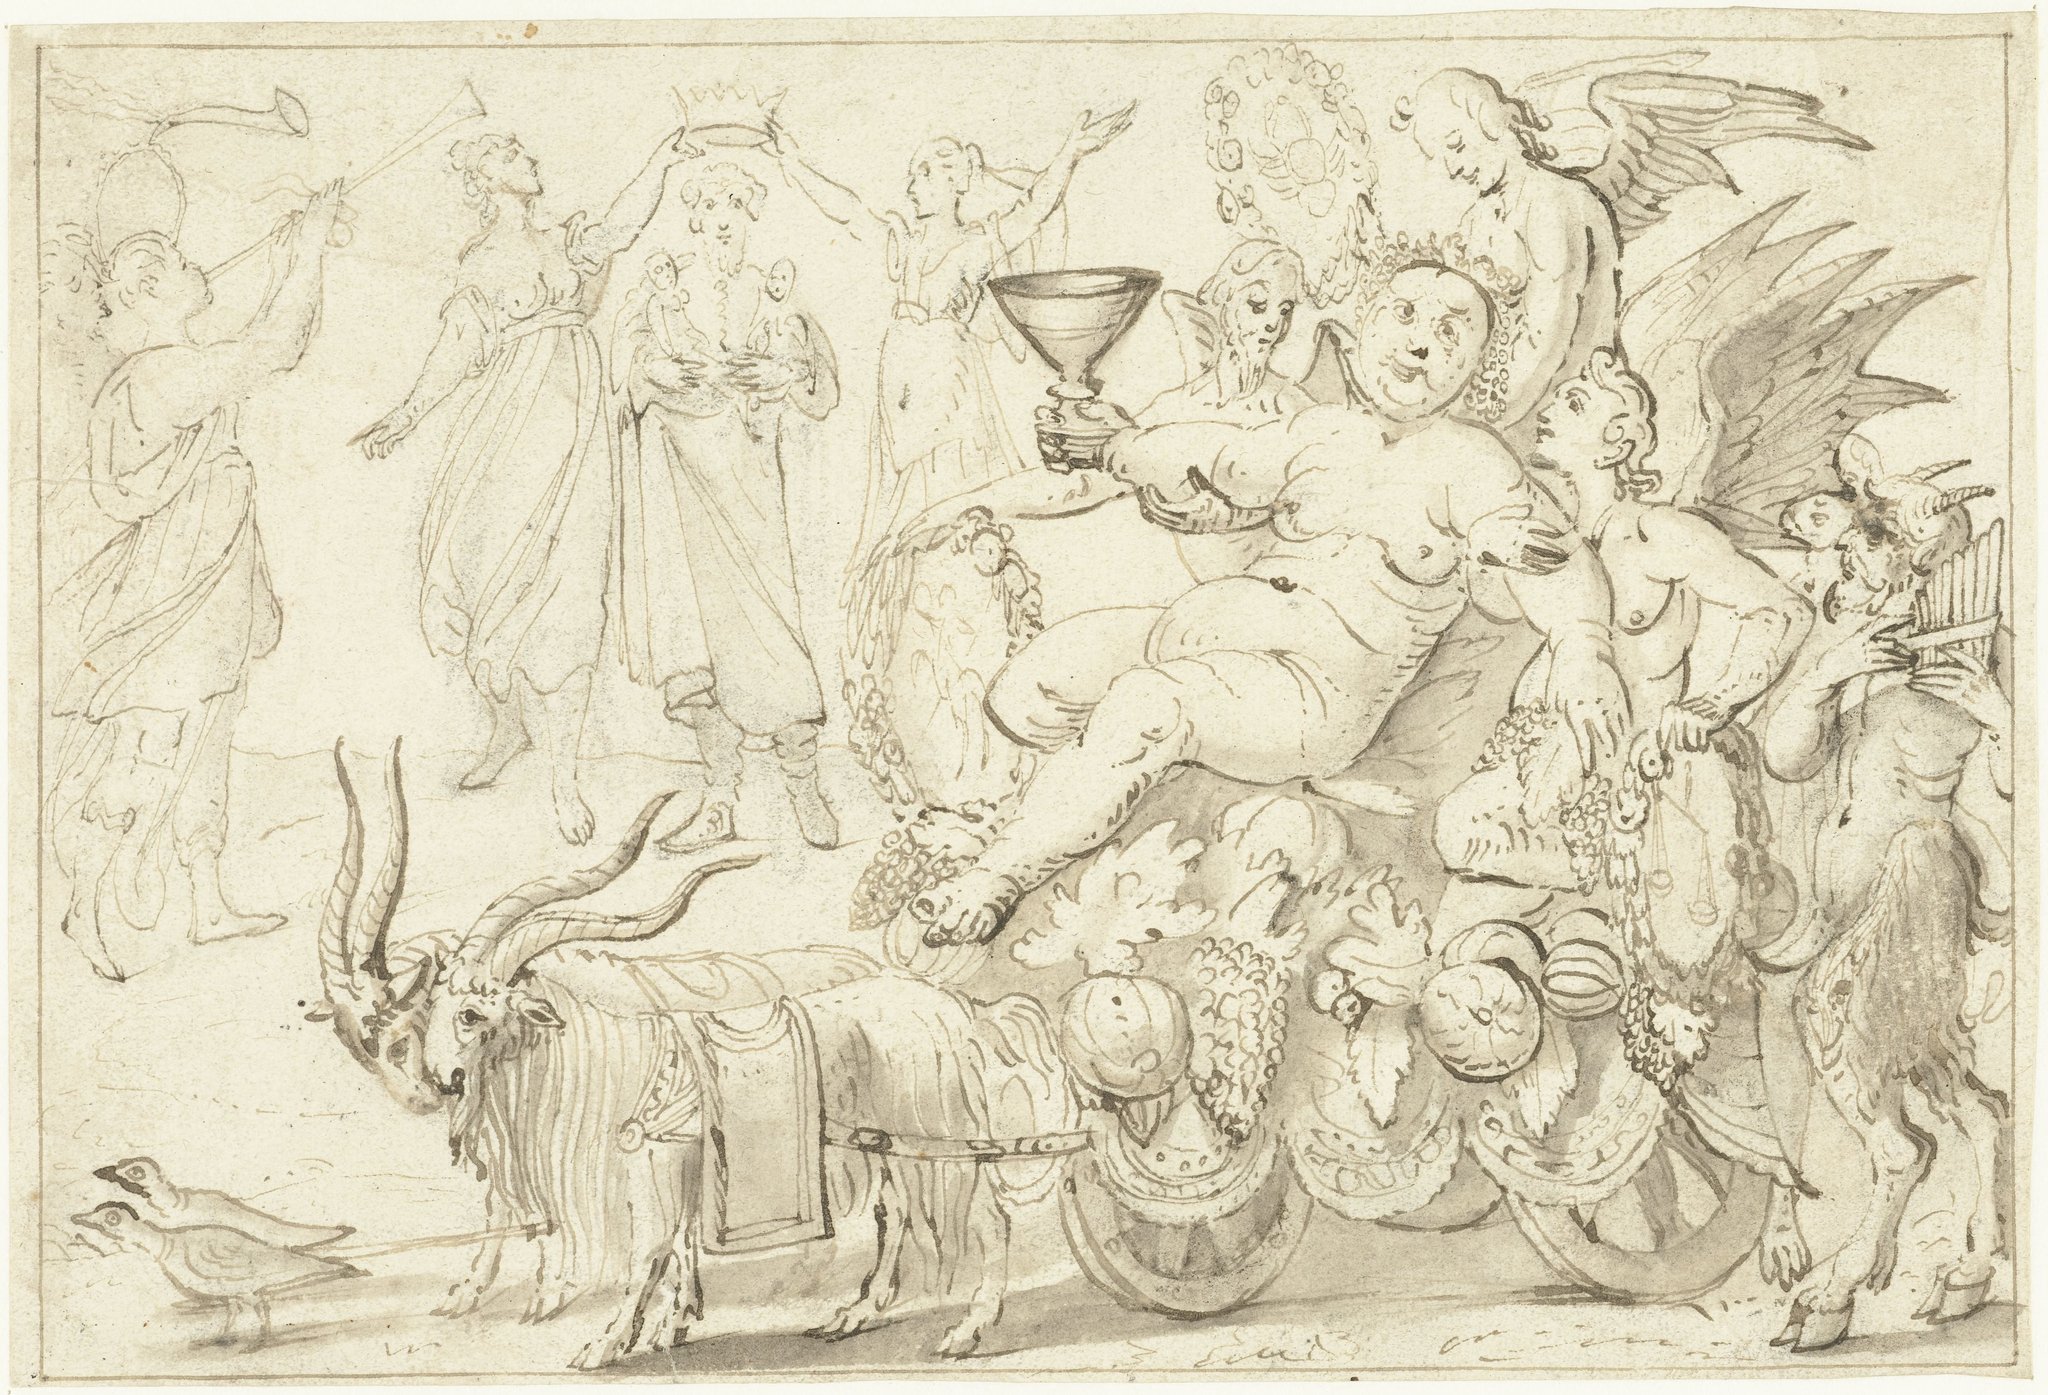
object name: drawing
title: Herfst of De triomf van Bacchus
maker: gerard ter borch (i)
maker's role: draughtsman, print maker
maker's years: 1584-1662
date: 1615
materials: chalk, ink, paper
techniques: brush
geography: zwolle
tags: autumn, fall, 'autumnus'; 'autunno' (ripa)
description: Vrij gekopieerd naar prent uit serie met de vier jaargetijden van Antonio Tempesta, Bar. 806. Serie nr. 3 (4).